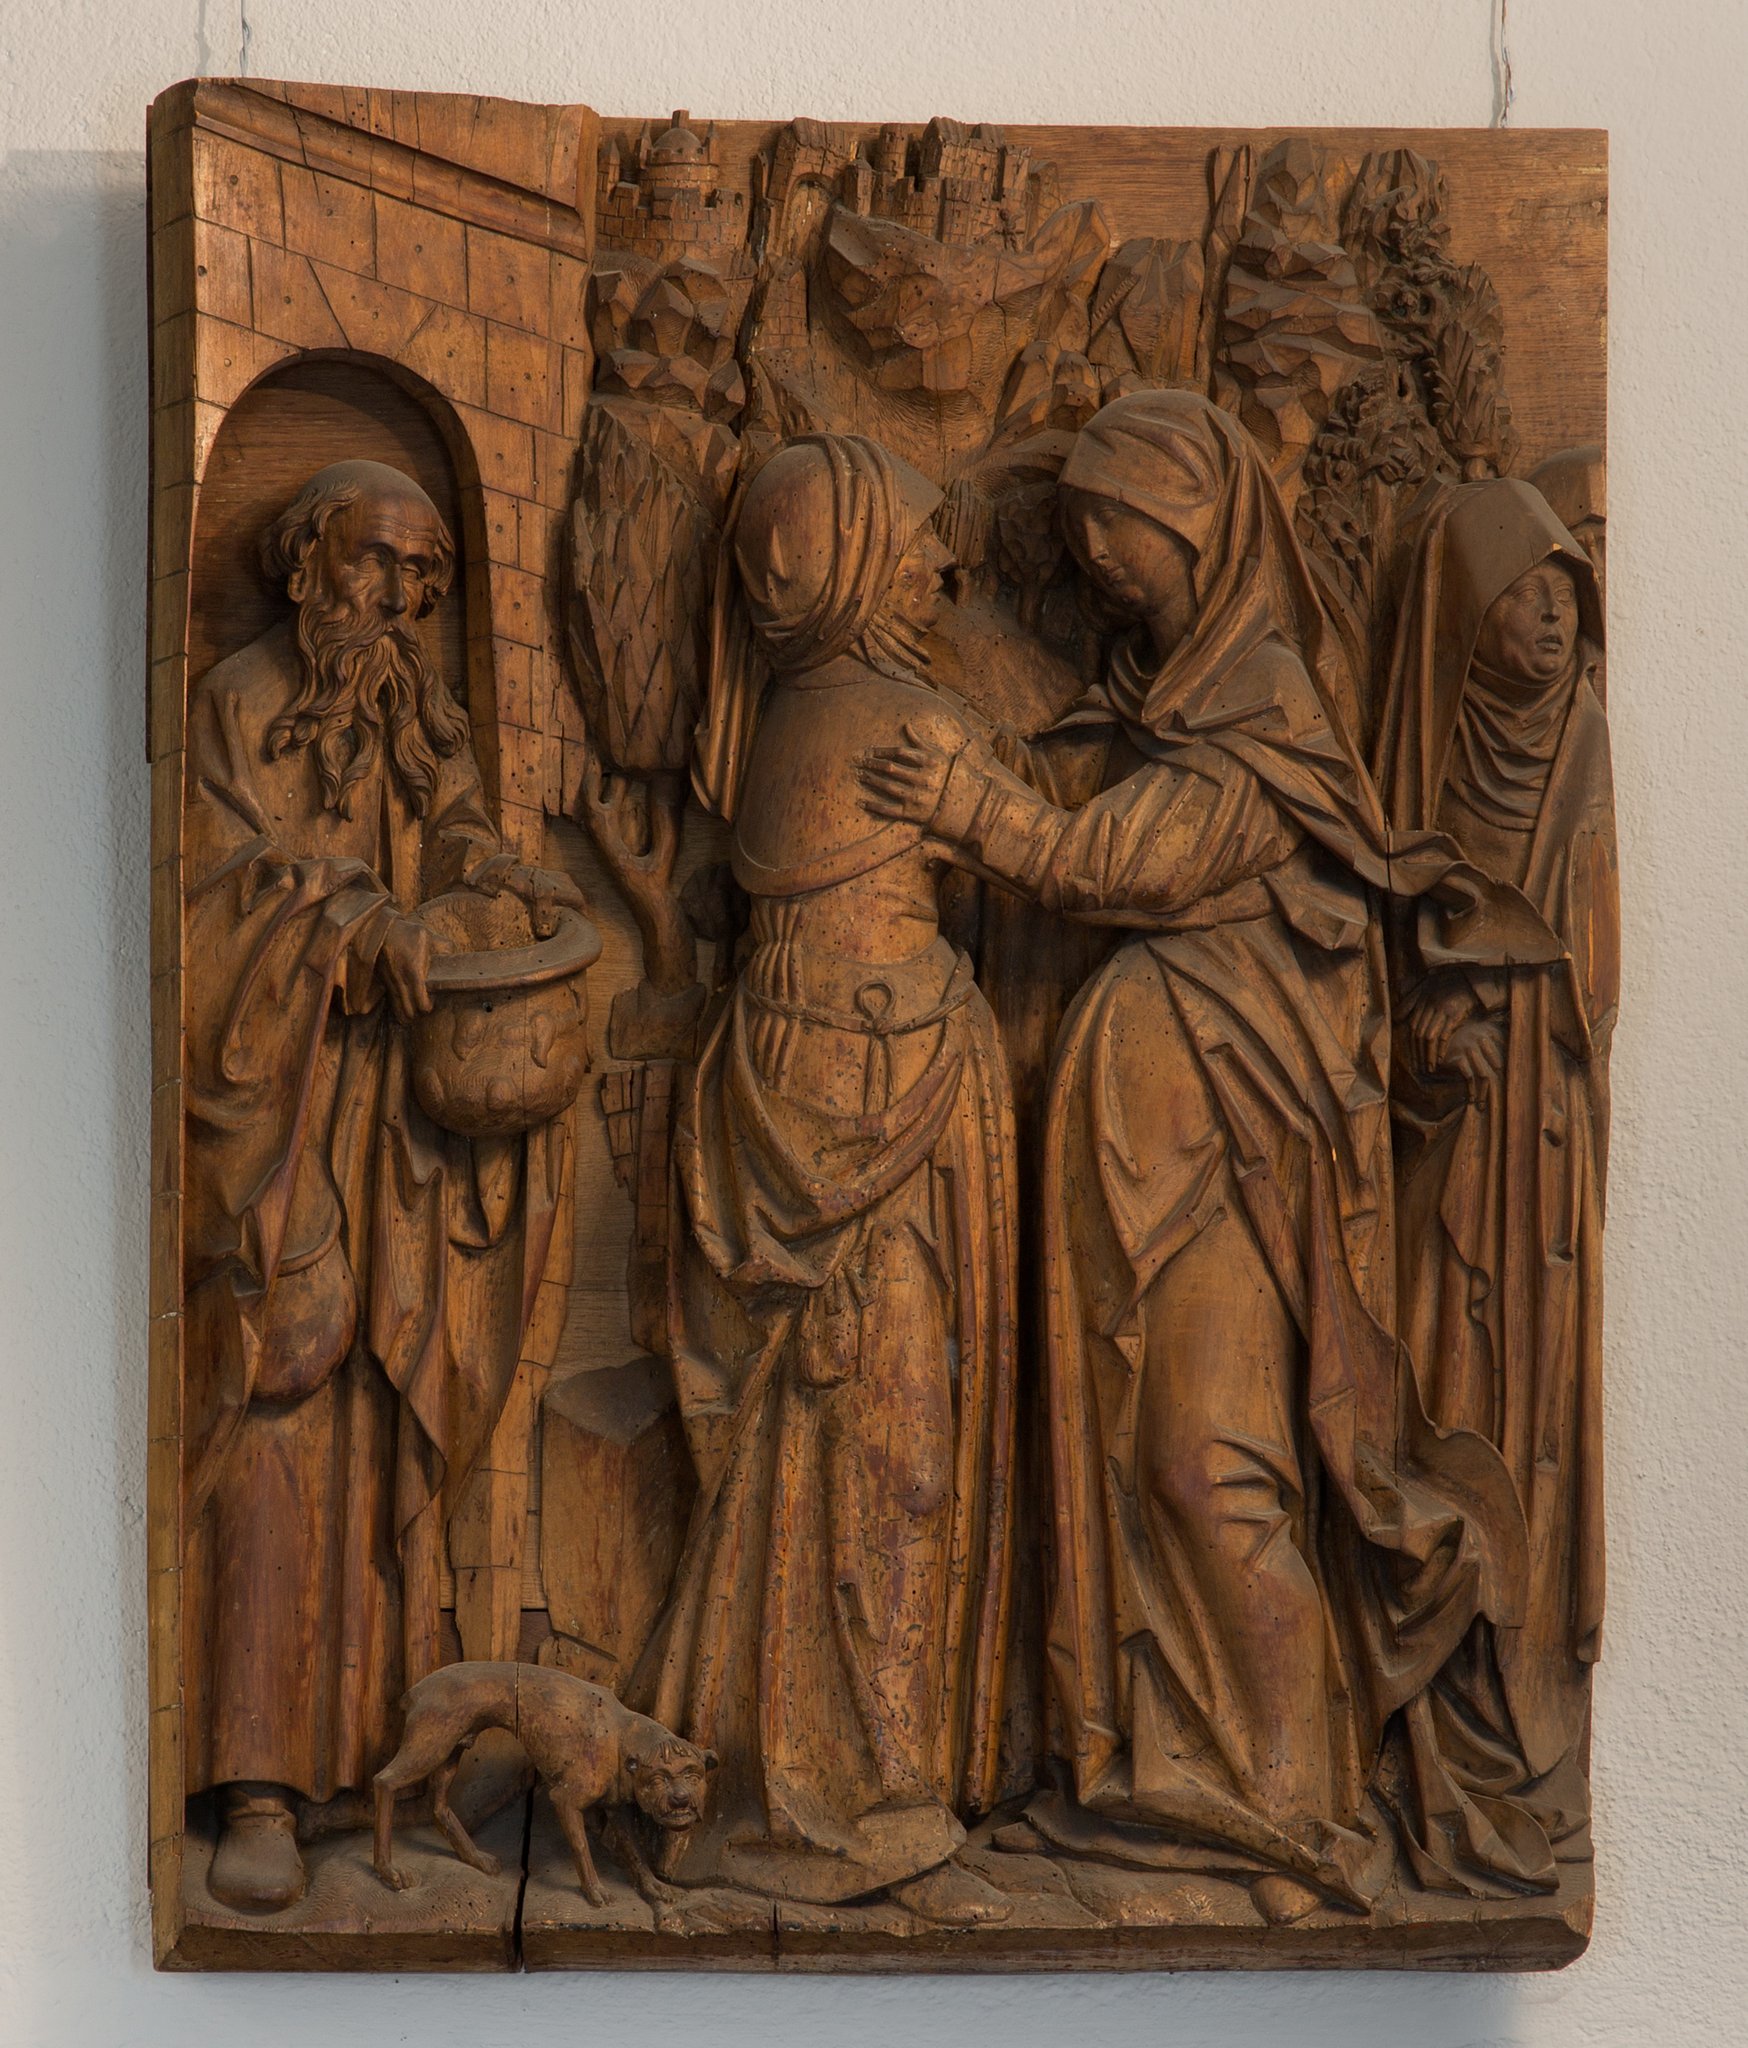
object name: relief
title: The Visitation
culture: german, south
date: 1520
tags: men,women,dogs,virgin mary,visitation